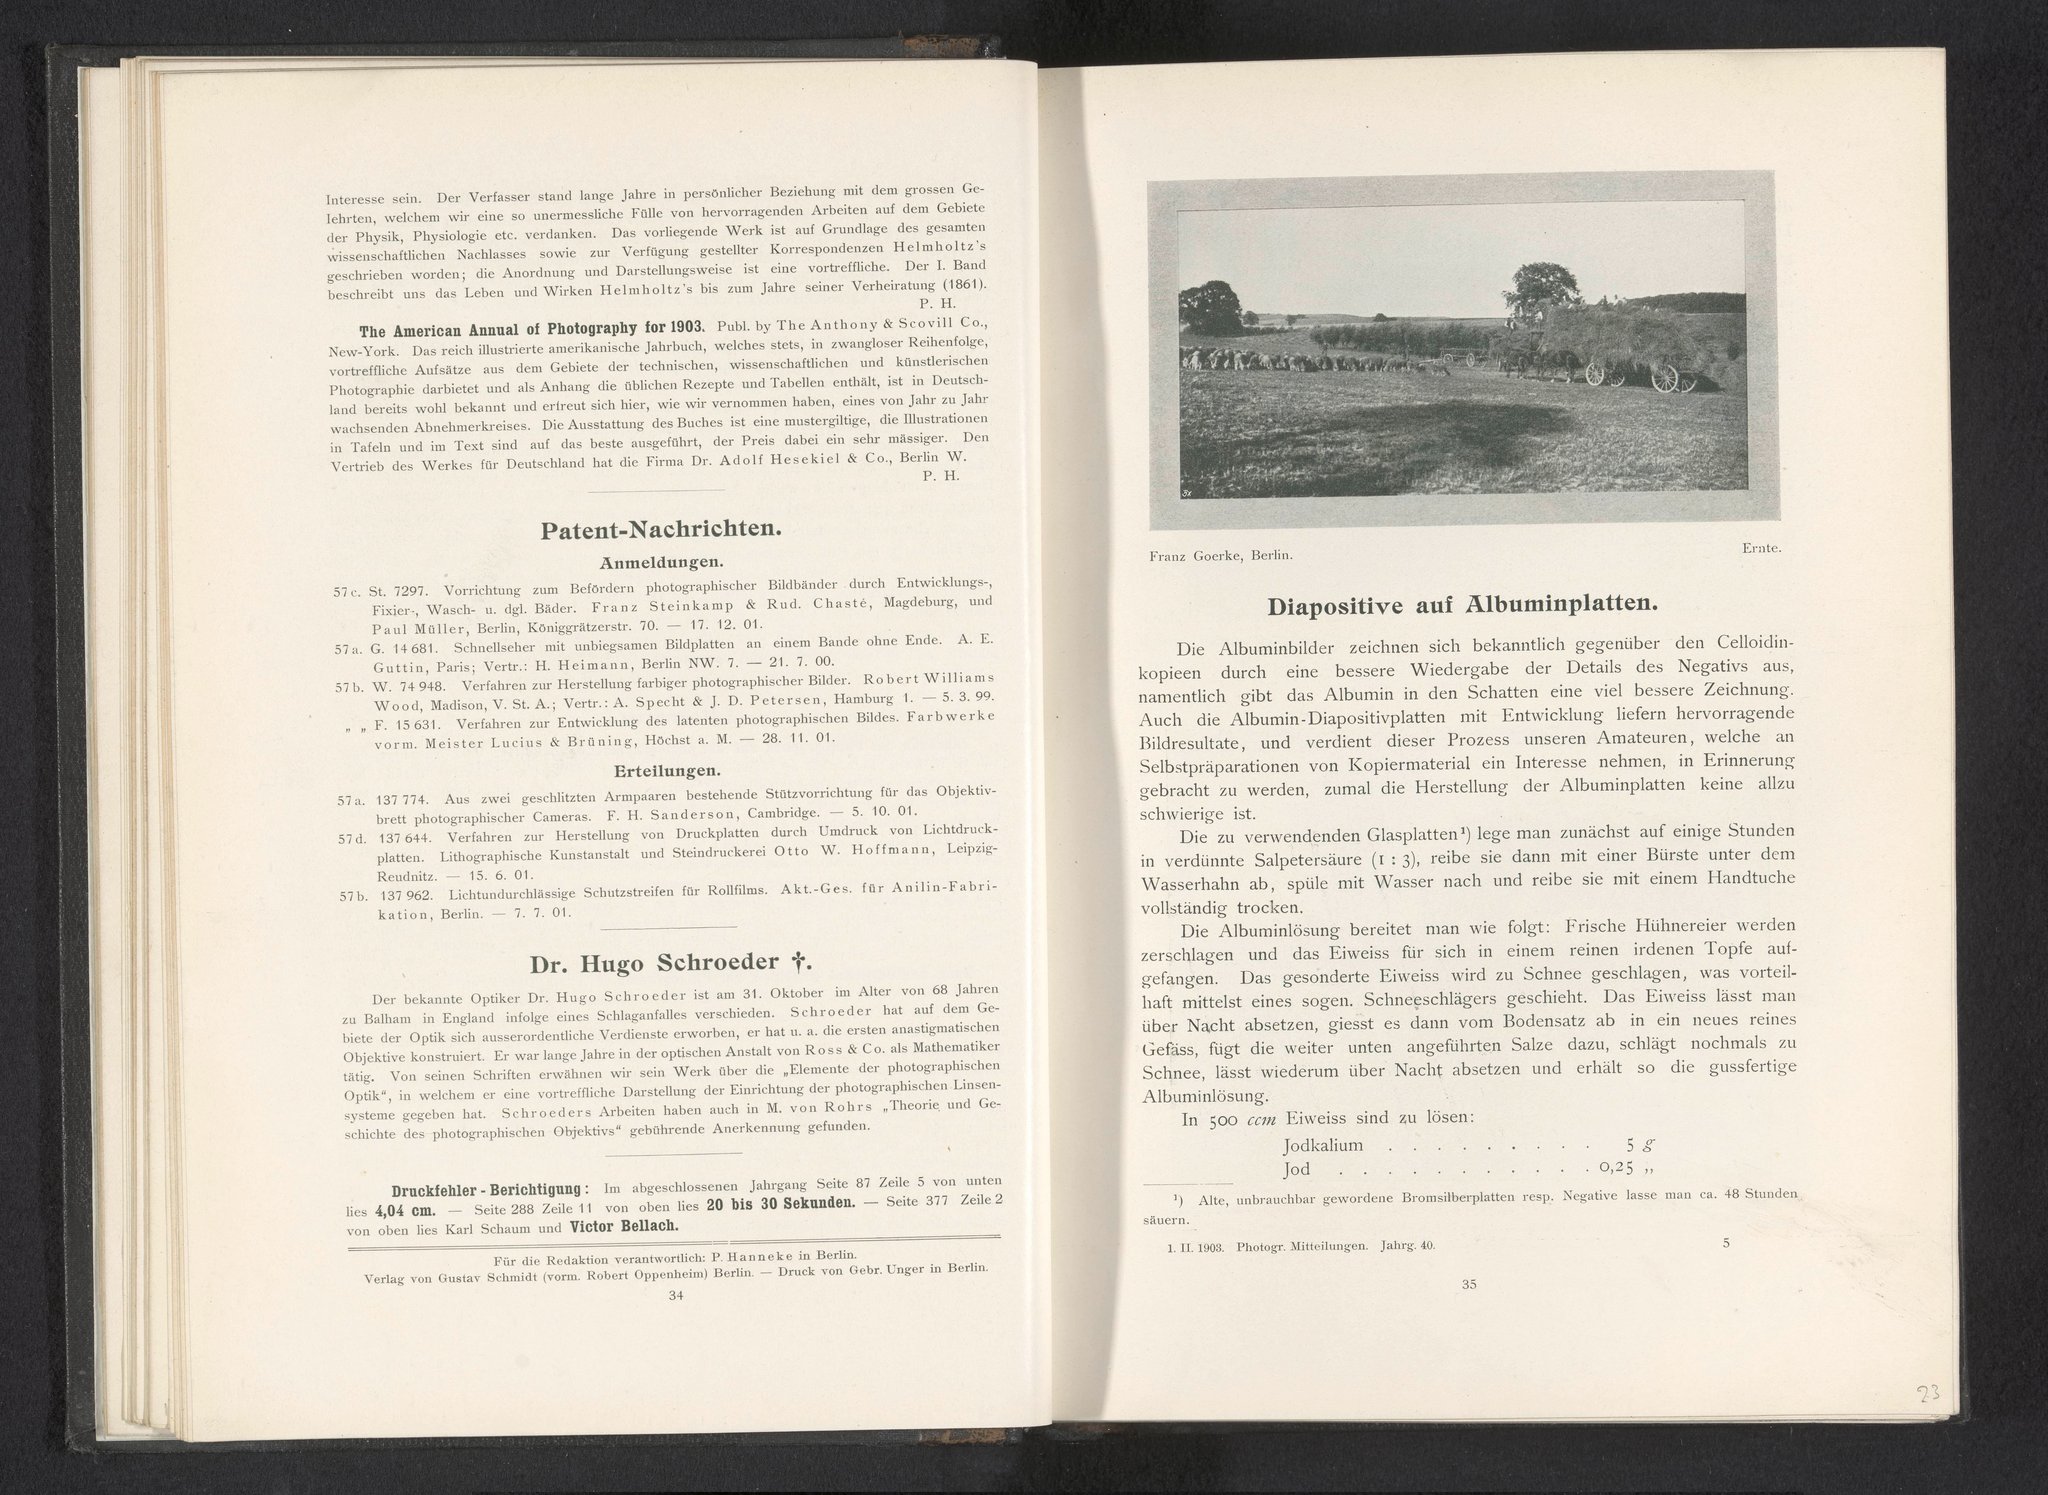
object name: photomechanical print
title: Ernte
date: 1898-1903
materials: paper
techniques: autotype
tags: harvest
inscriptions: inscription: ‘Berlin’, monogram: ‘BX’